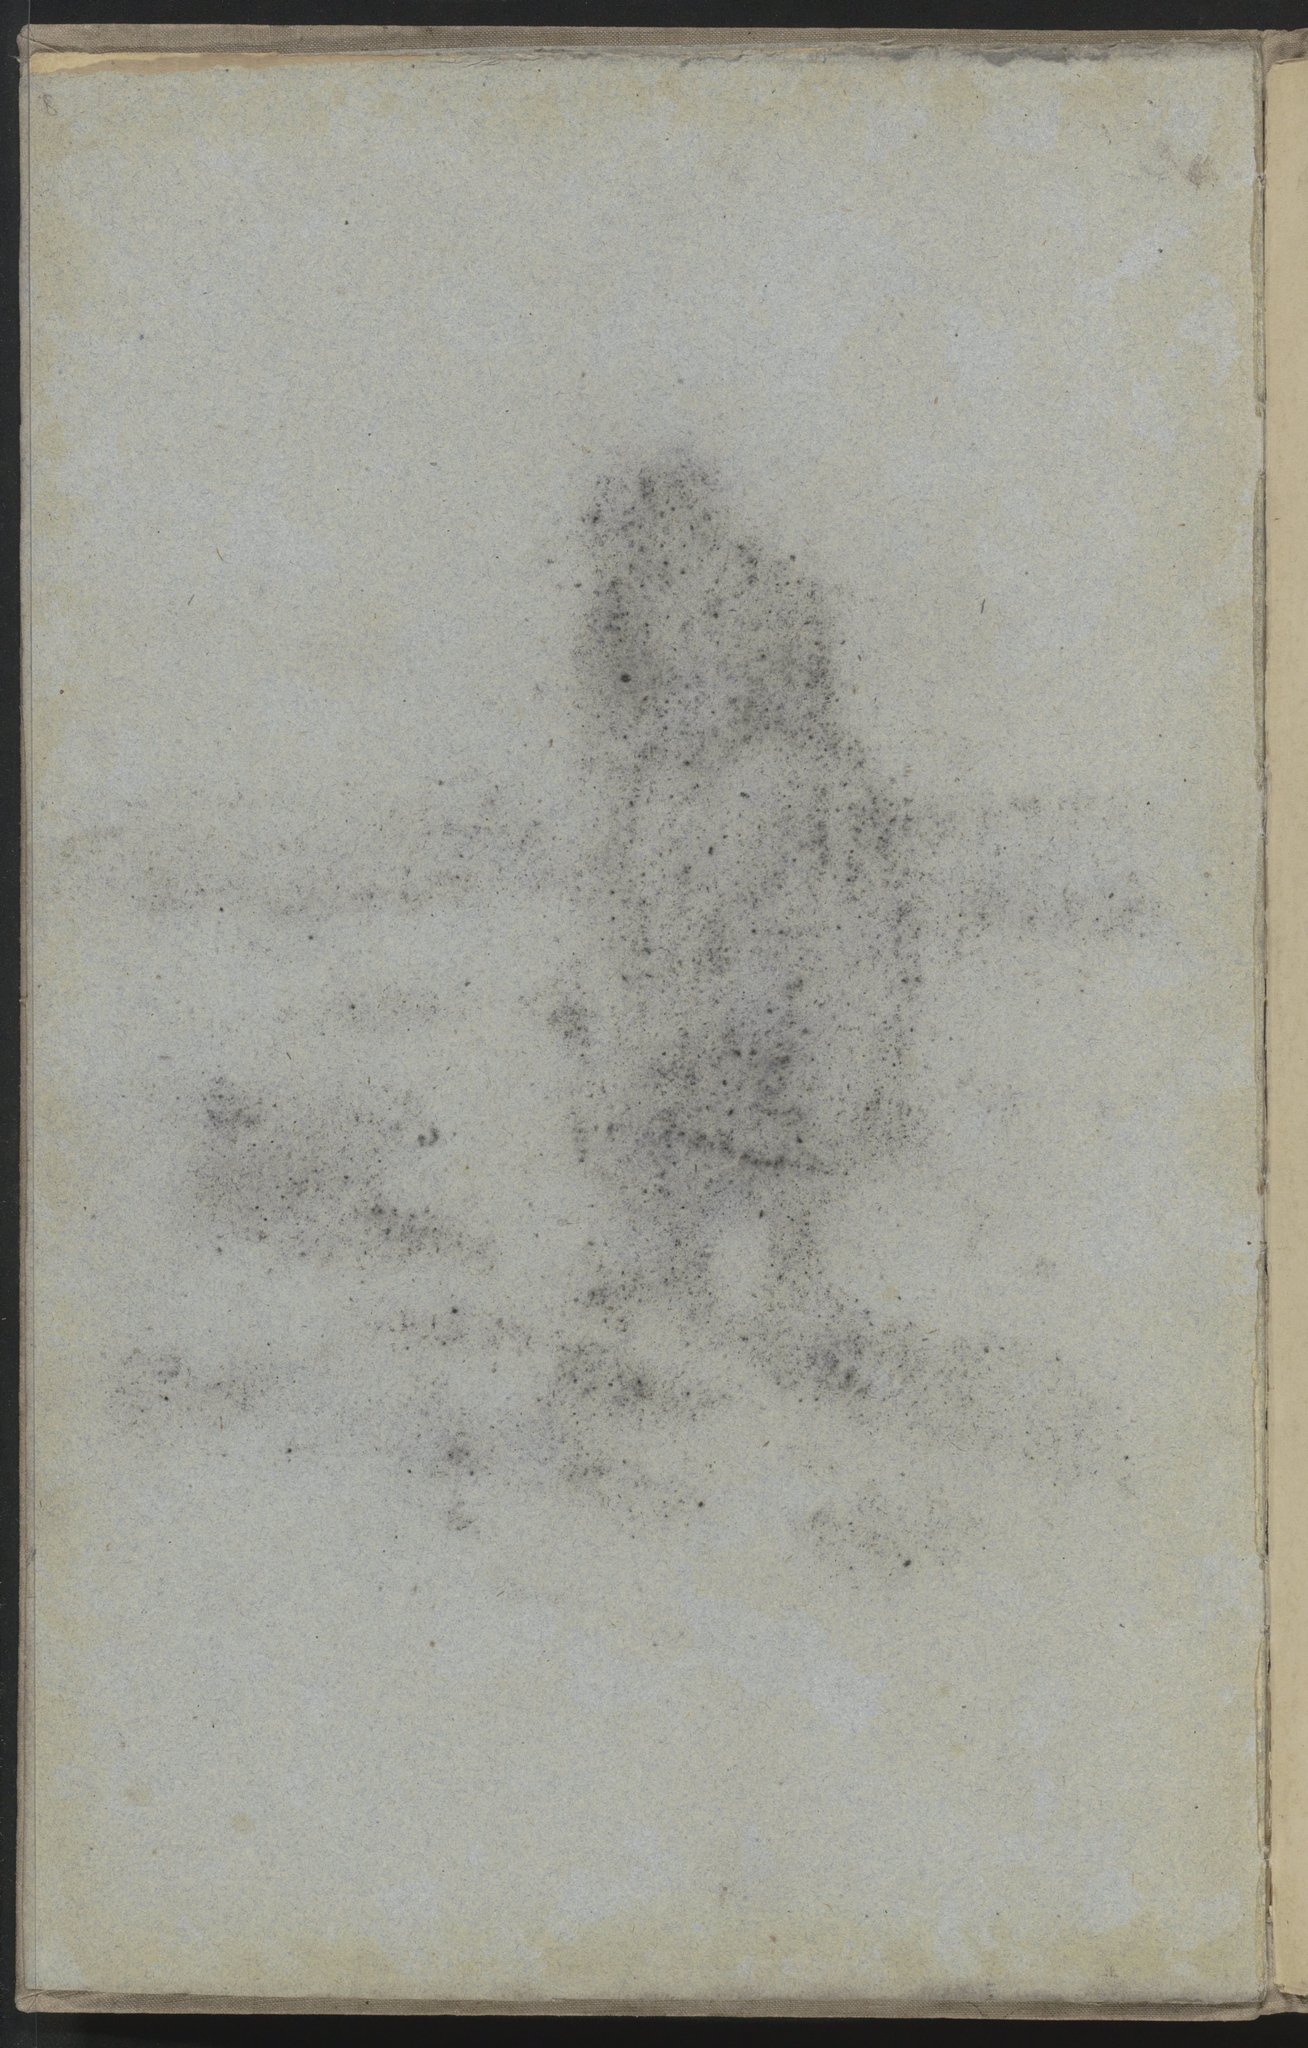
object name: sketchbook leaf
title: Abklatsch van de krijttekening op pagina 9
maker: willem witsen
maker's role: draughtsman, painter, print maker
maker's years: 1860-1923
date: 1886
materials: paper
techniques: printmaking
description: Pagina 8 uit een schetsboek met 38 bladen betekend rond de Ewijkshoeve.